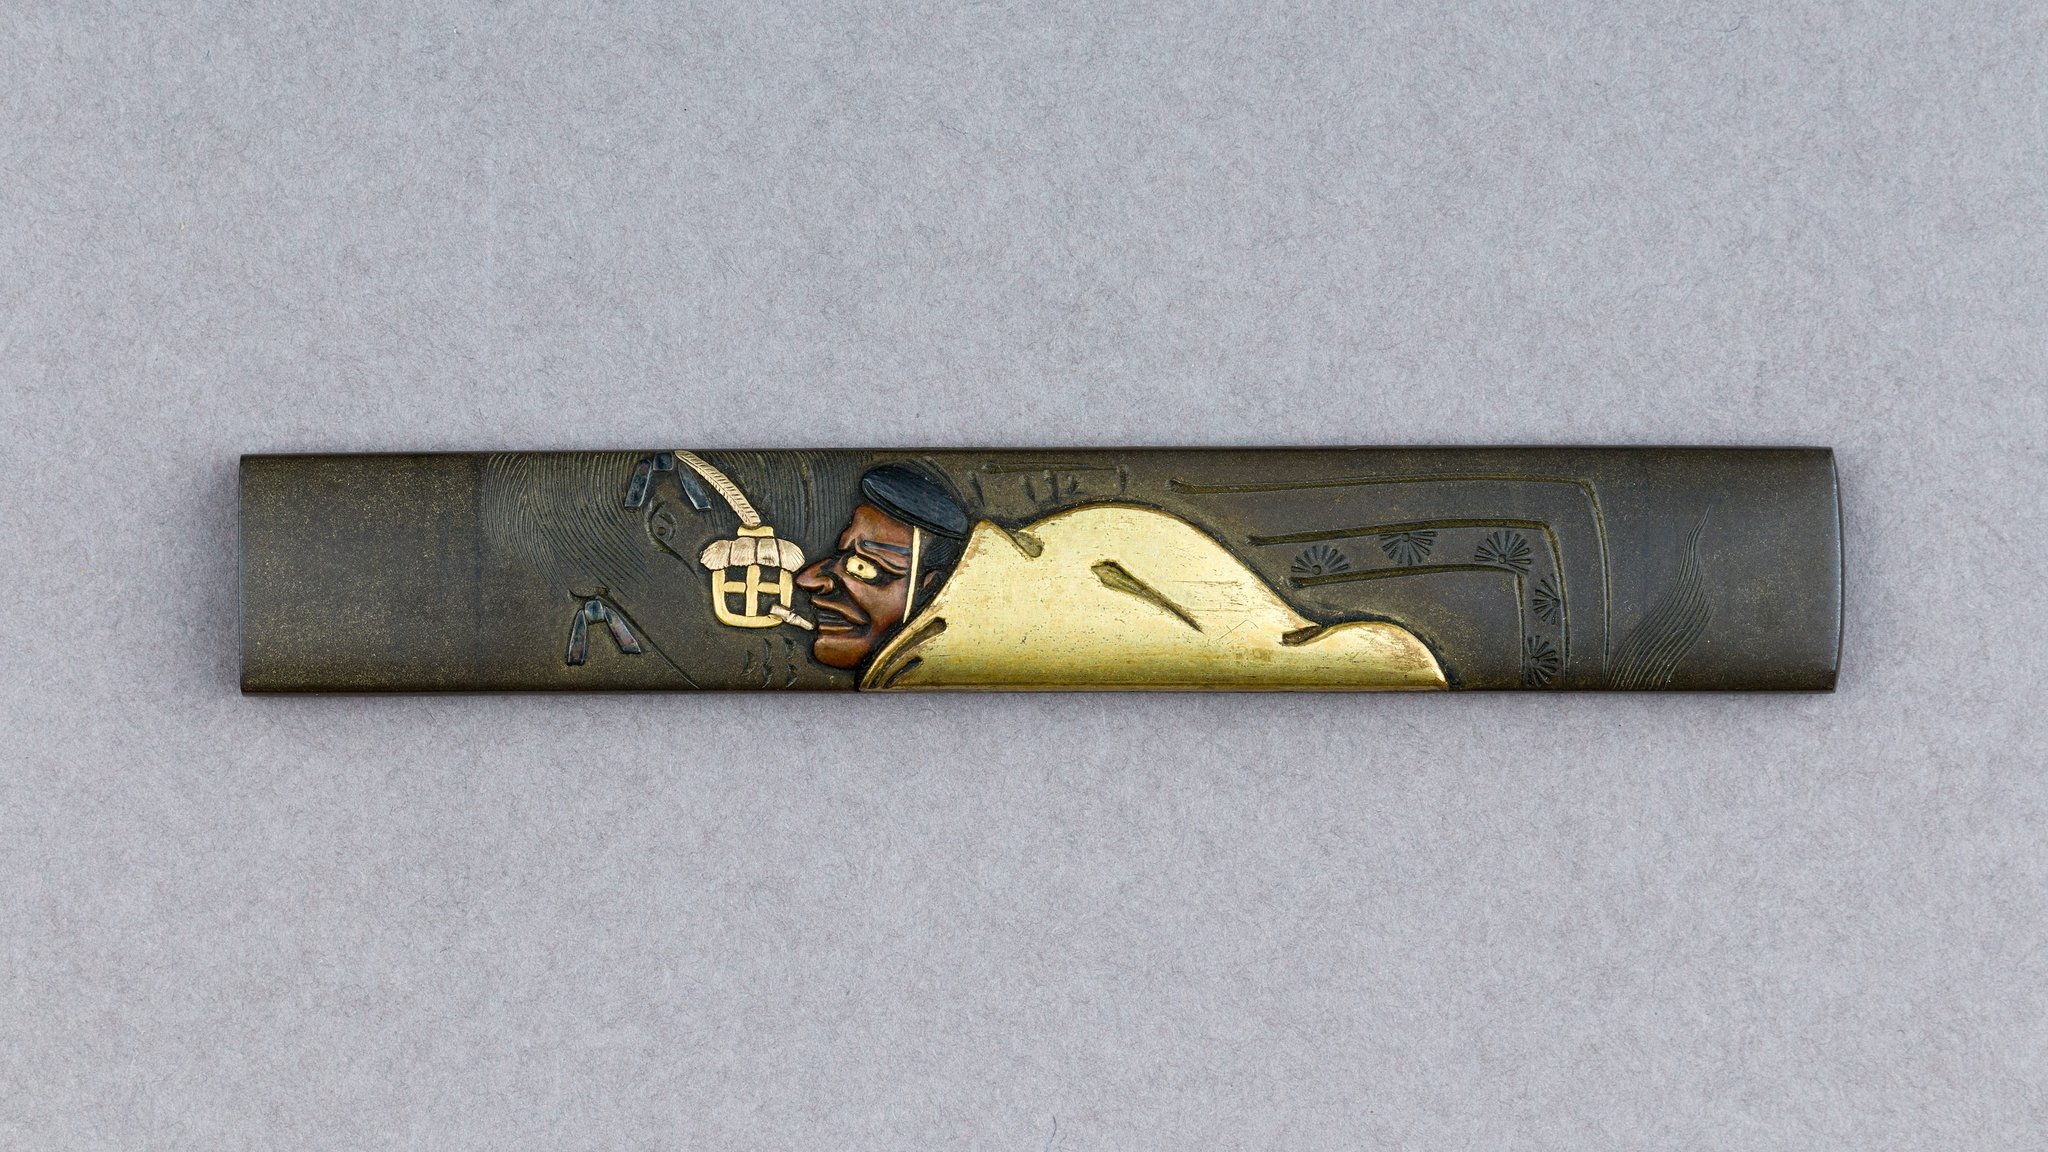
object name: knife handle kozuka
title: Knife Handle (Kozuka)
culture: japanese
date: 1785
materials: copper, gold alloy, silver alloy, gold, silver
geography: japan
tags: men